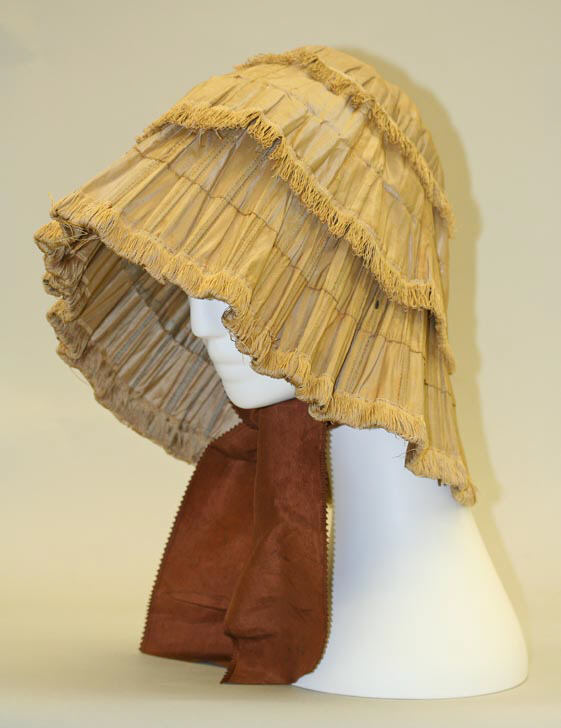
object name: hat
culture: french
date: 1830-1839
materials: silk